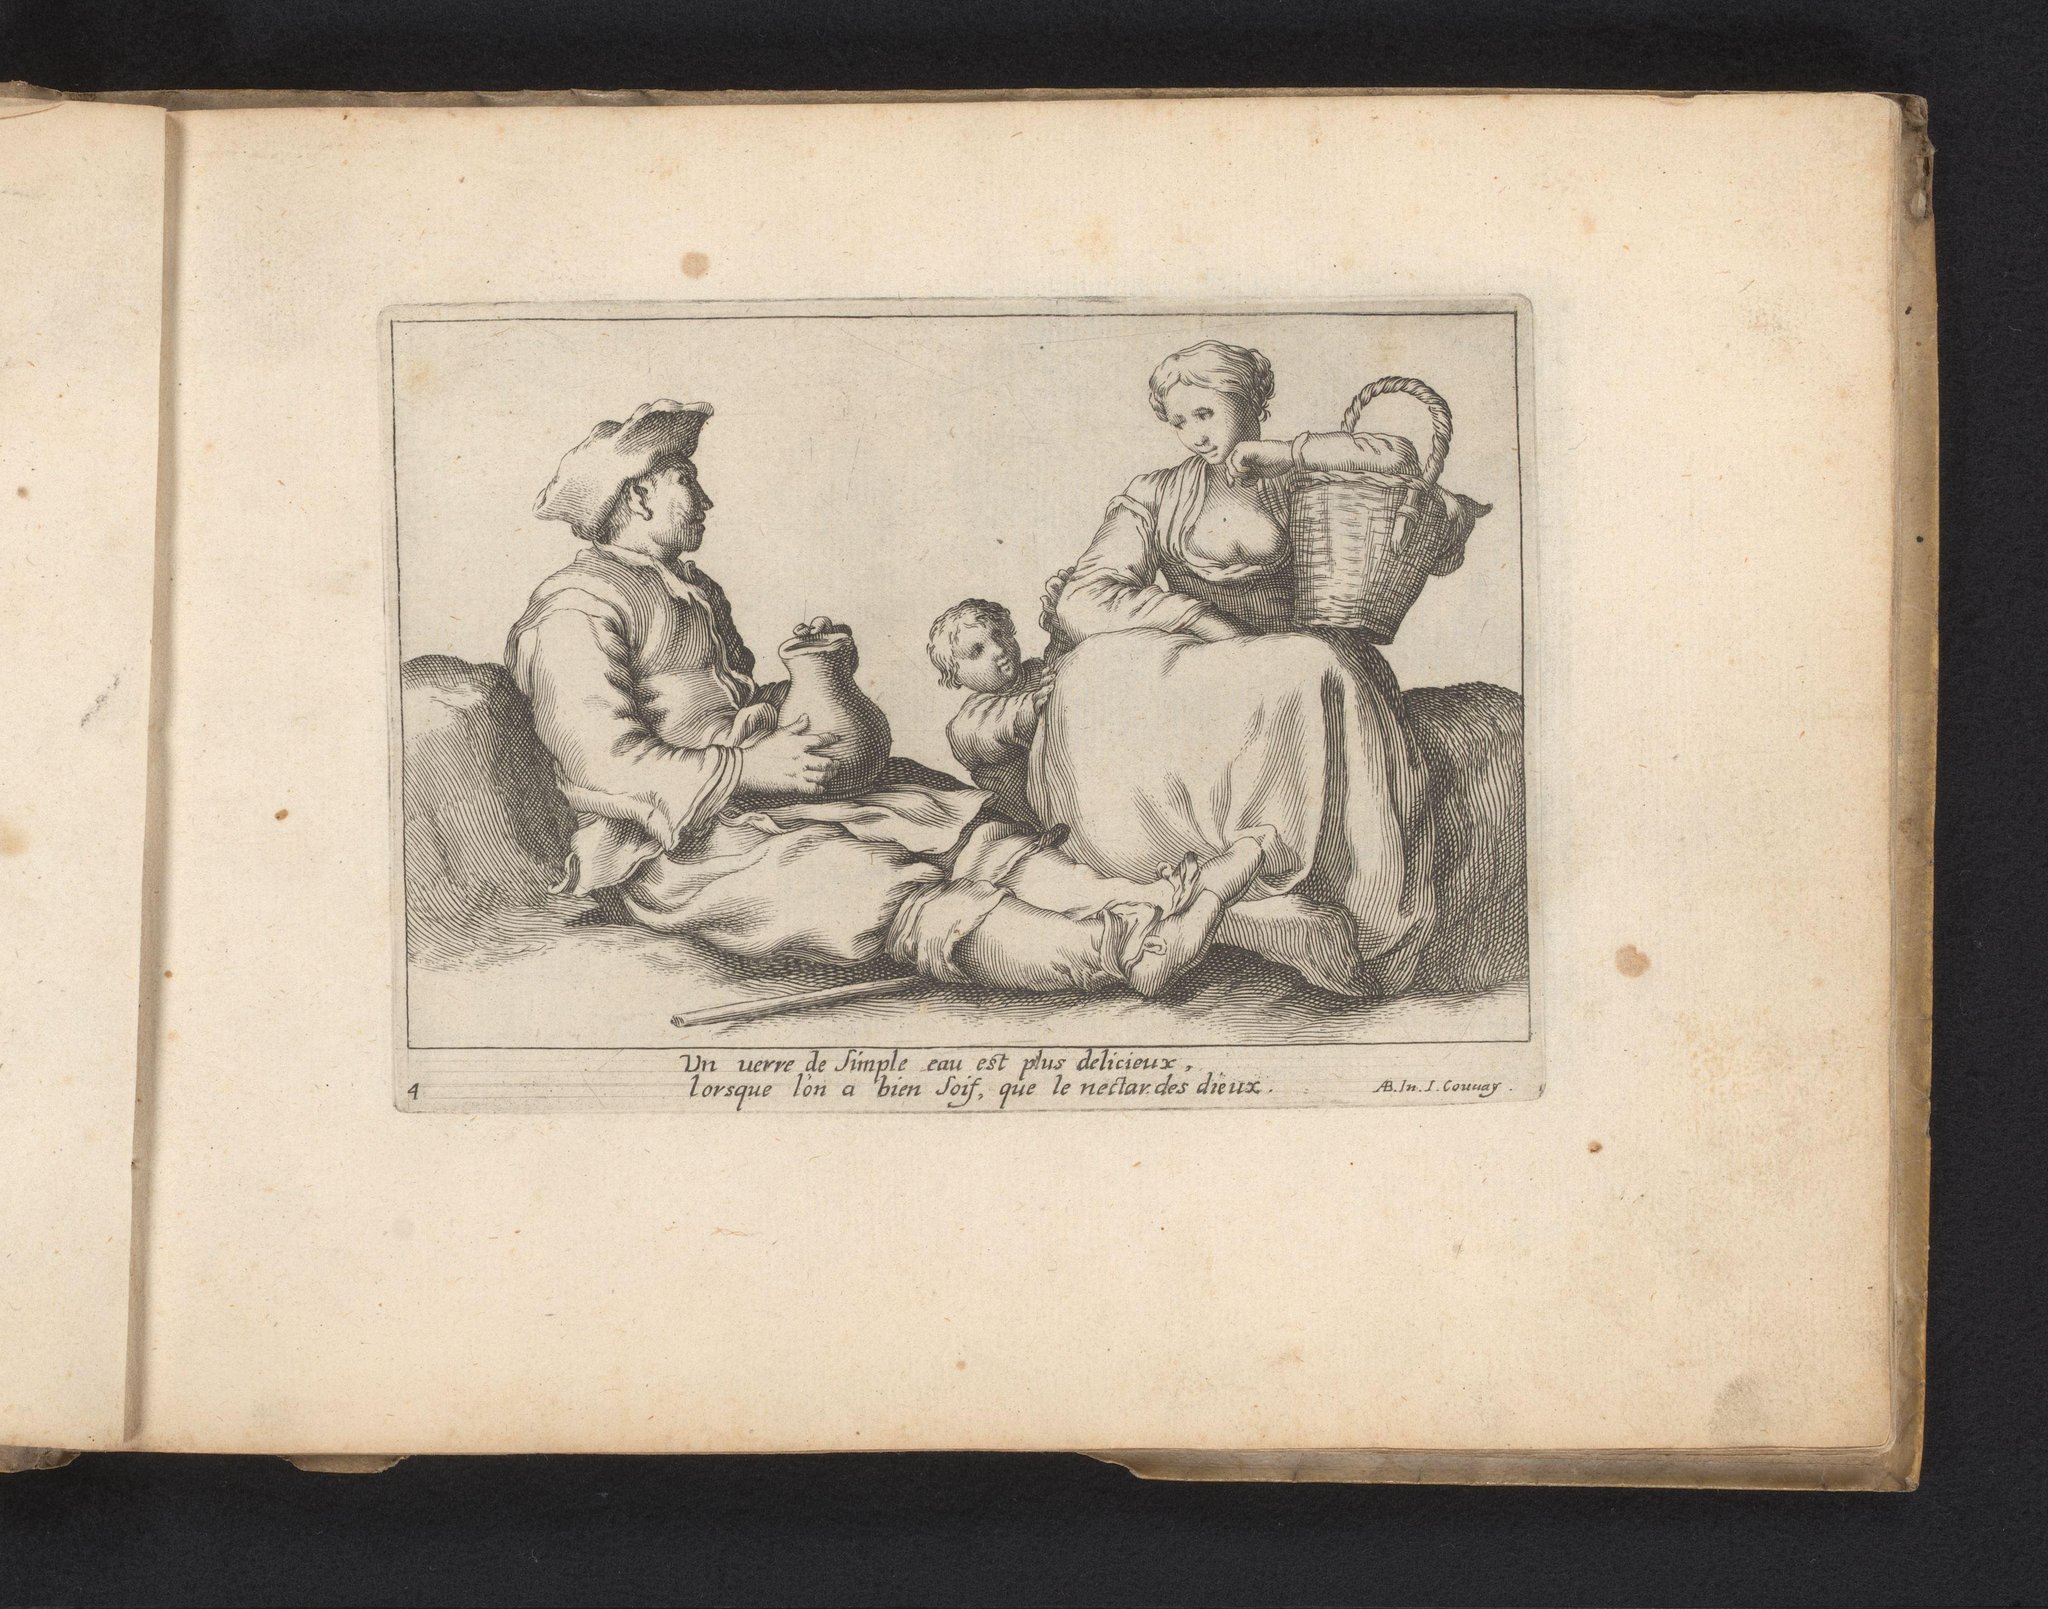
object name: album leaf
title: Figuren in landschappen naar Bloemaert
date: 1632-1675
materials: paper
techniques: etching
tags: jar, jug (used as drinking-vessel), (traveller) resting in the open air, container made of plant material other than wood: basket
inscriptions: collector's mark: ‘Bibliotheek/ Rijksmuseum/ Amsterdam’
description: Deze prent maakt deel uit van een album.